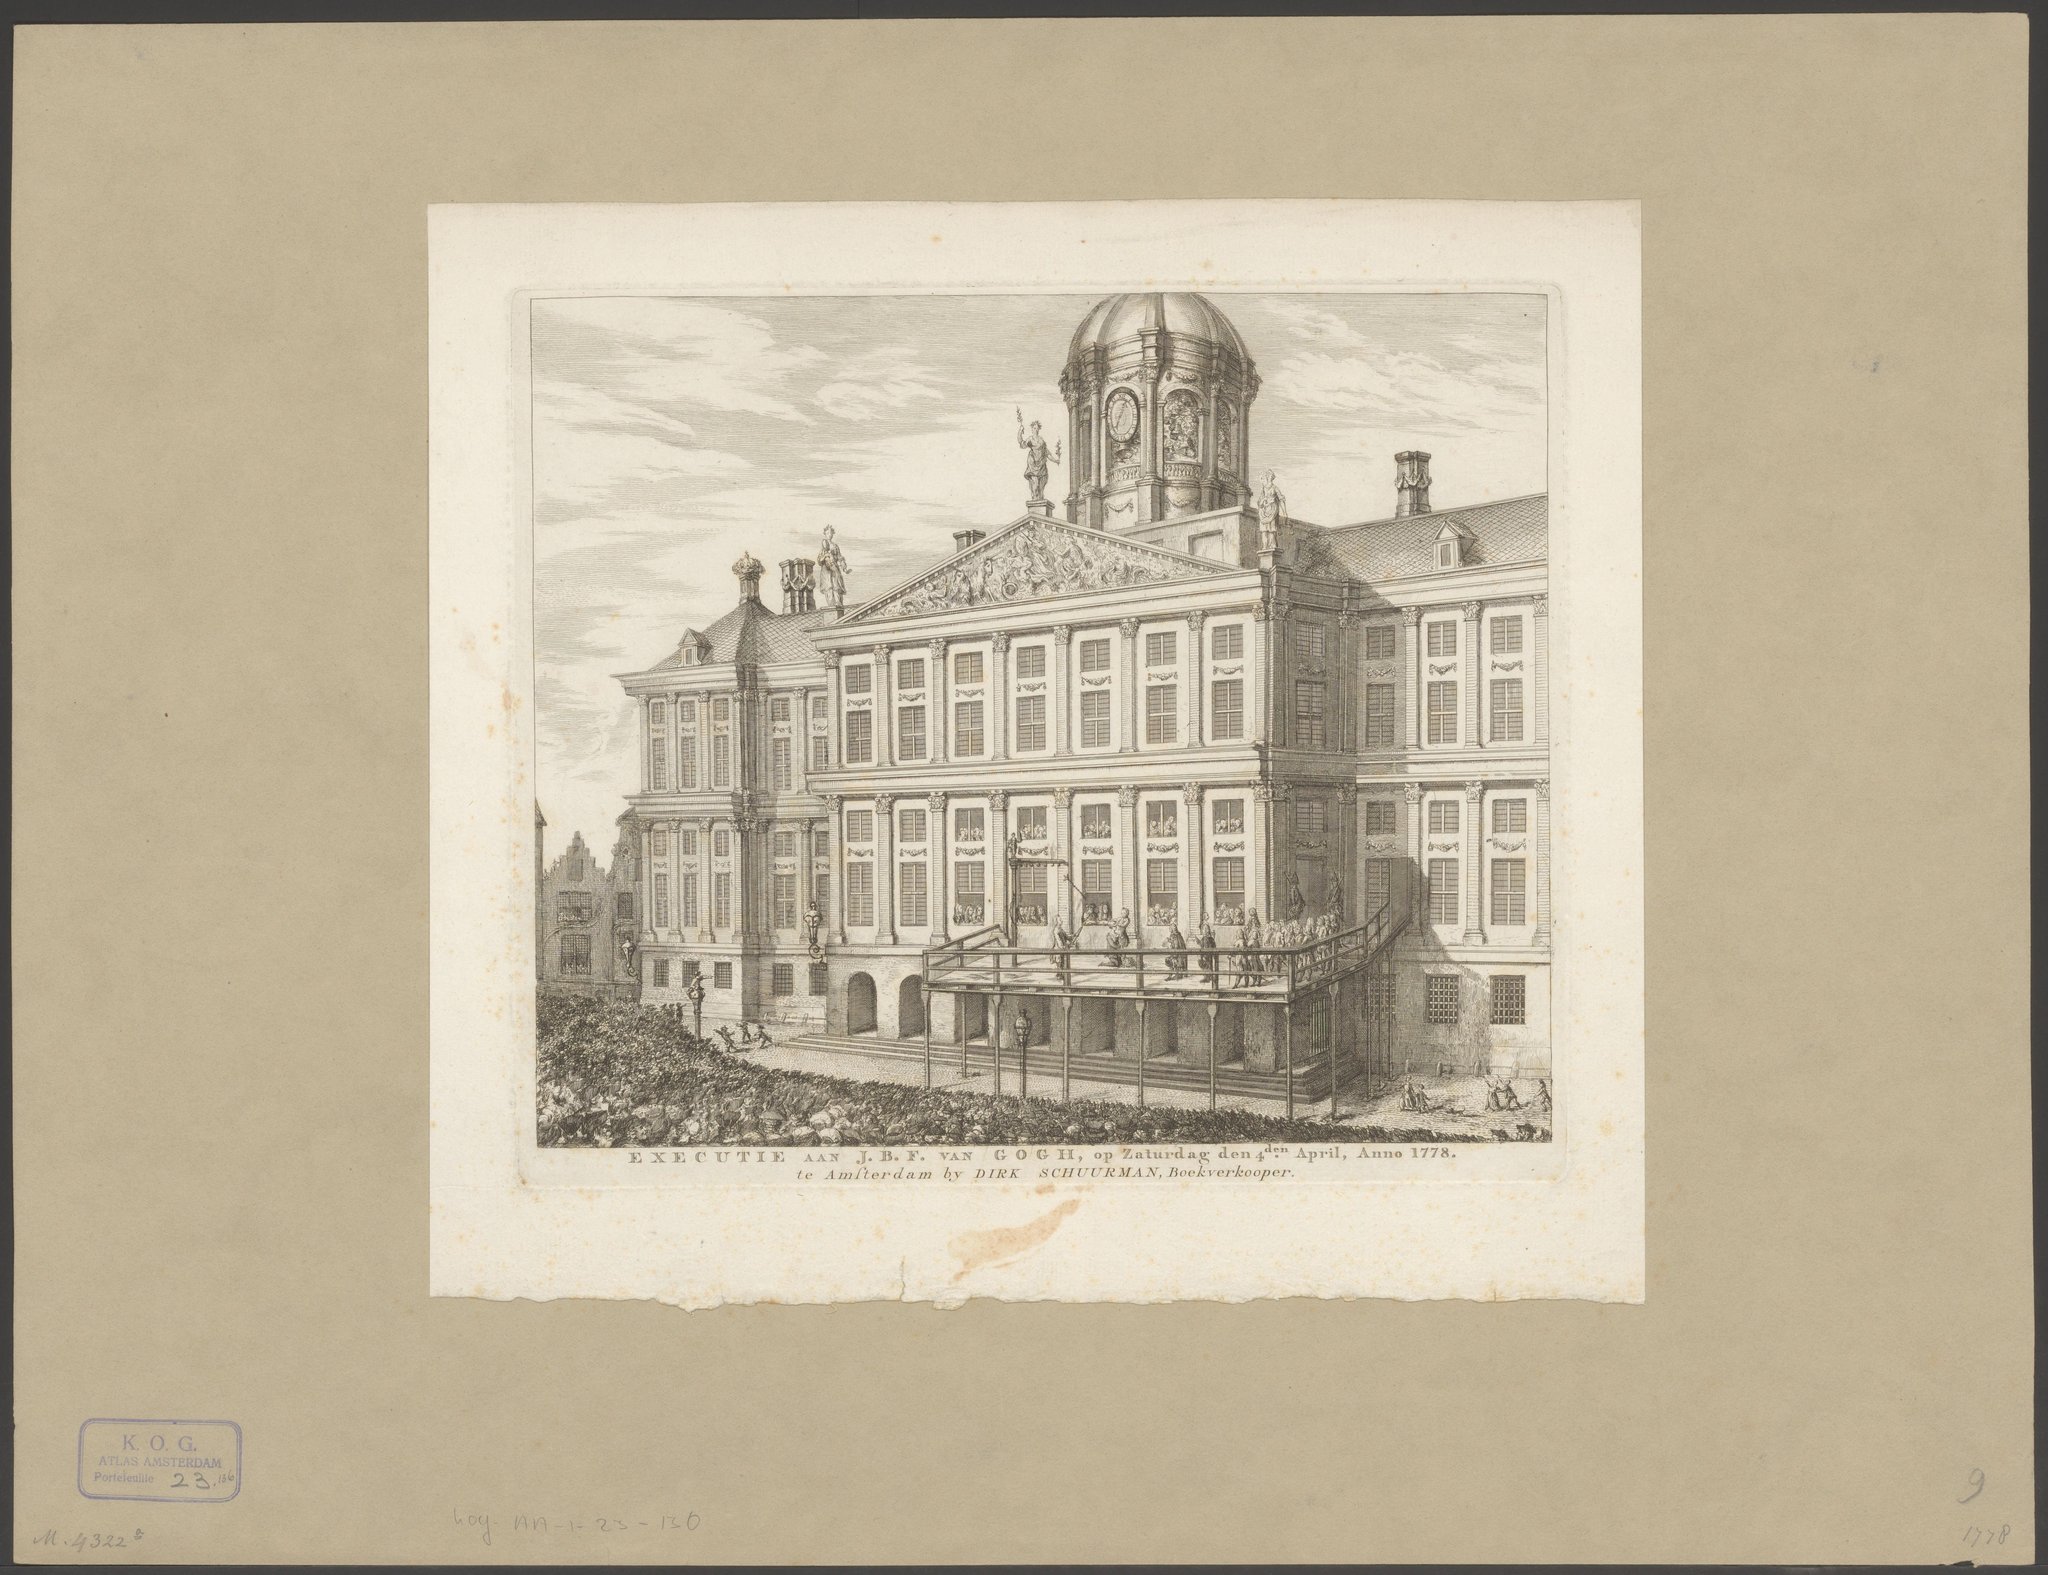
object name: print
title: Executie aan J.B.F. van Gogh, op Zaturdag den 4den April, Anno 1778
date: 1778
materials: paper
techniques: engraving, etching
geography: amsterdam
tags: amsterdam, johannes bartholomeus ferdinandus van gogh, on the scaffold or place of execution, violent death by beheading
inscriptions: collector's mark: Lugt 1641b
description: Onderwerpsrubriek binnen de Atlas Amsterdam: Rechtswezen.